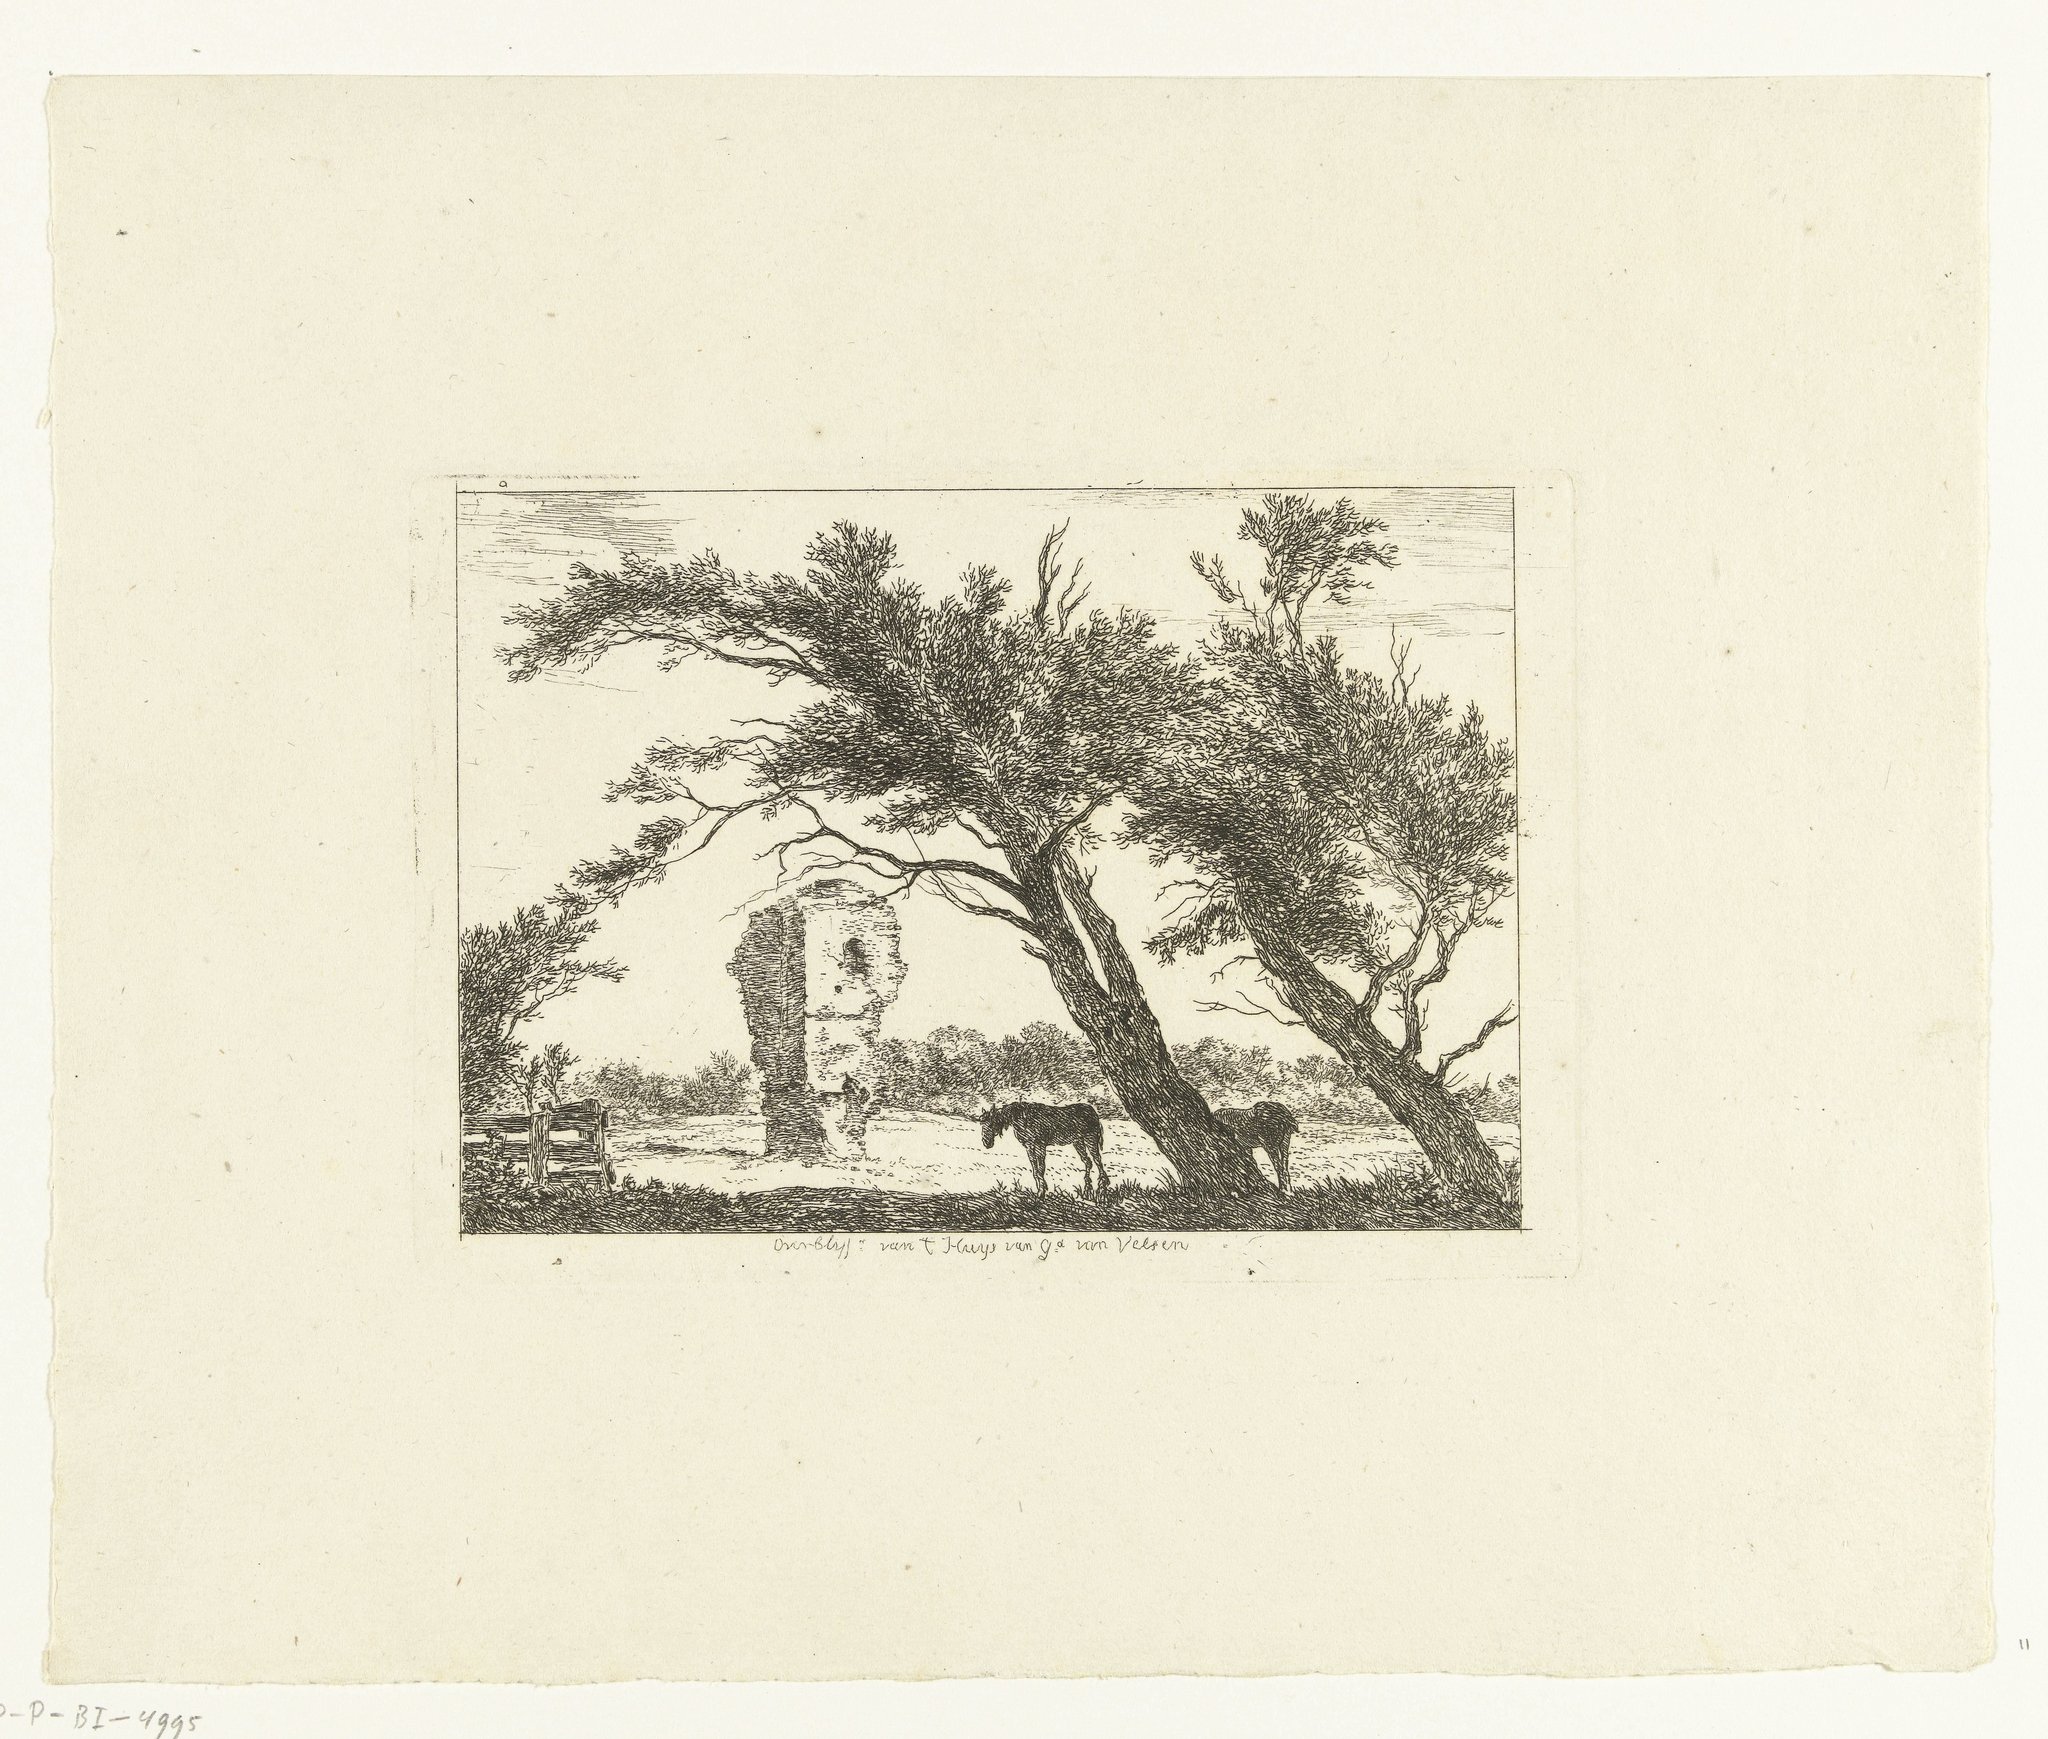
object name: print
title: Overblijfselen van het huis van Gerard van Velsen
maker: hermanus van brussel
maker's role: draughtsman, print maker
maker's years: 1763-1815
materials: paper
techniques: etching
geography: netherlands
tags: landscapes in the temperate zone, ruin of a dwelling, house, castle, etc.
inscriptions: collector's mark: Lugt 2228